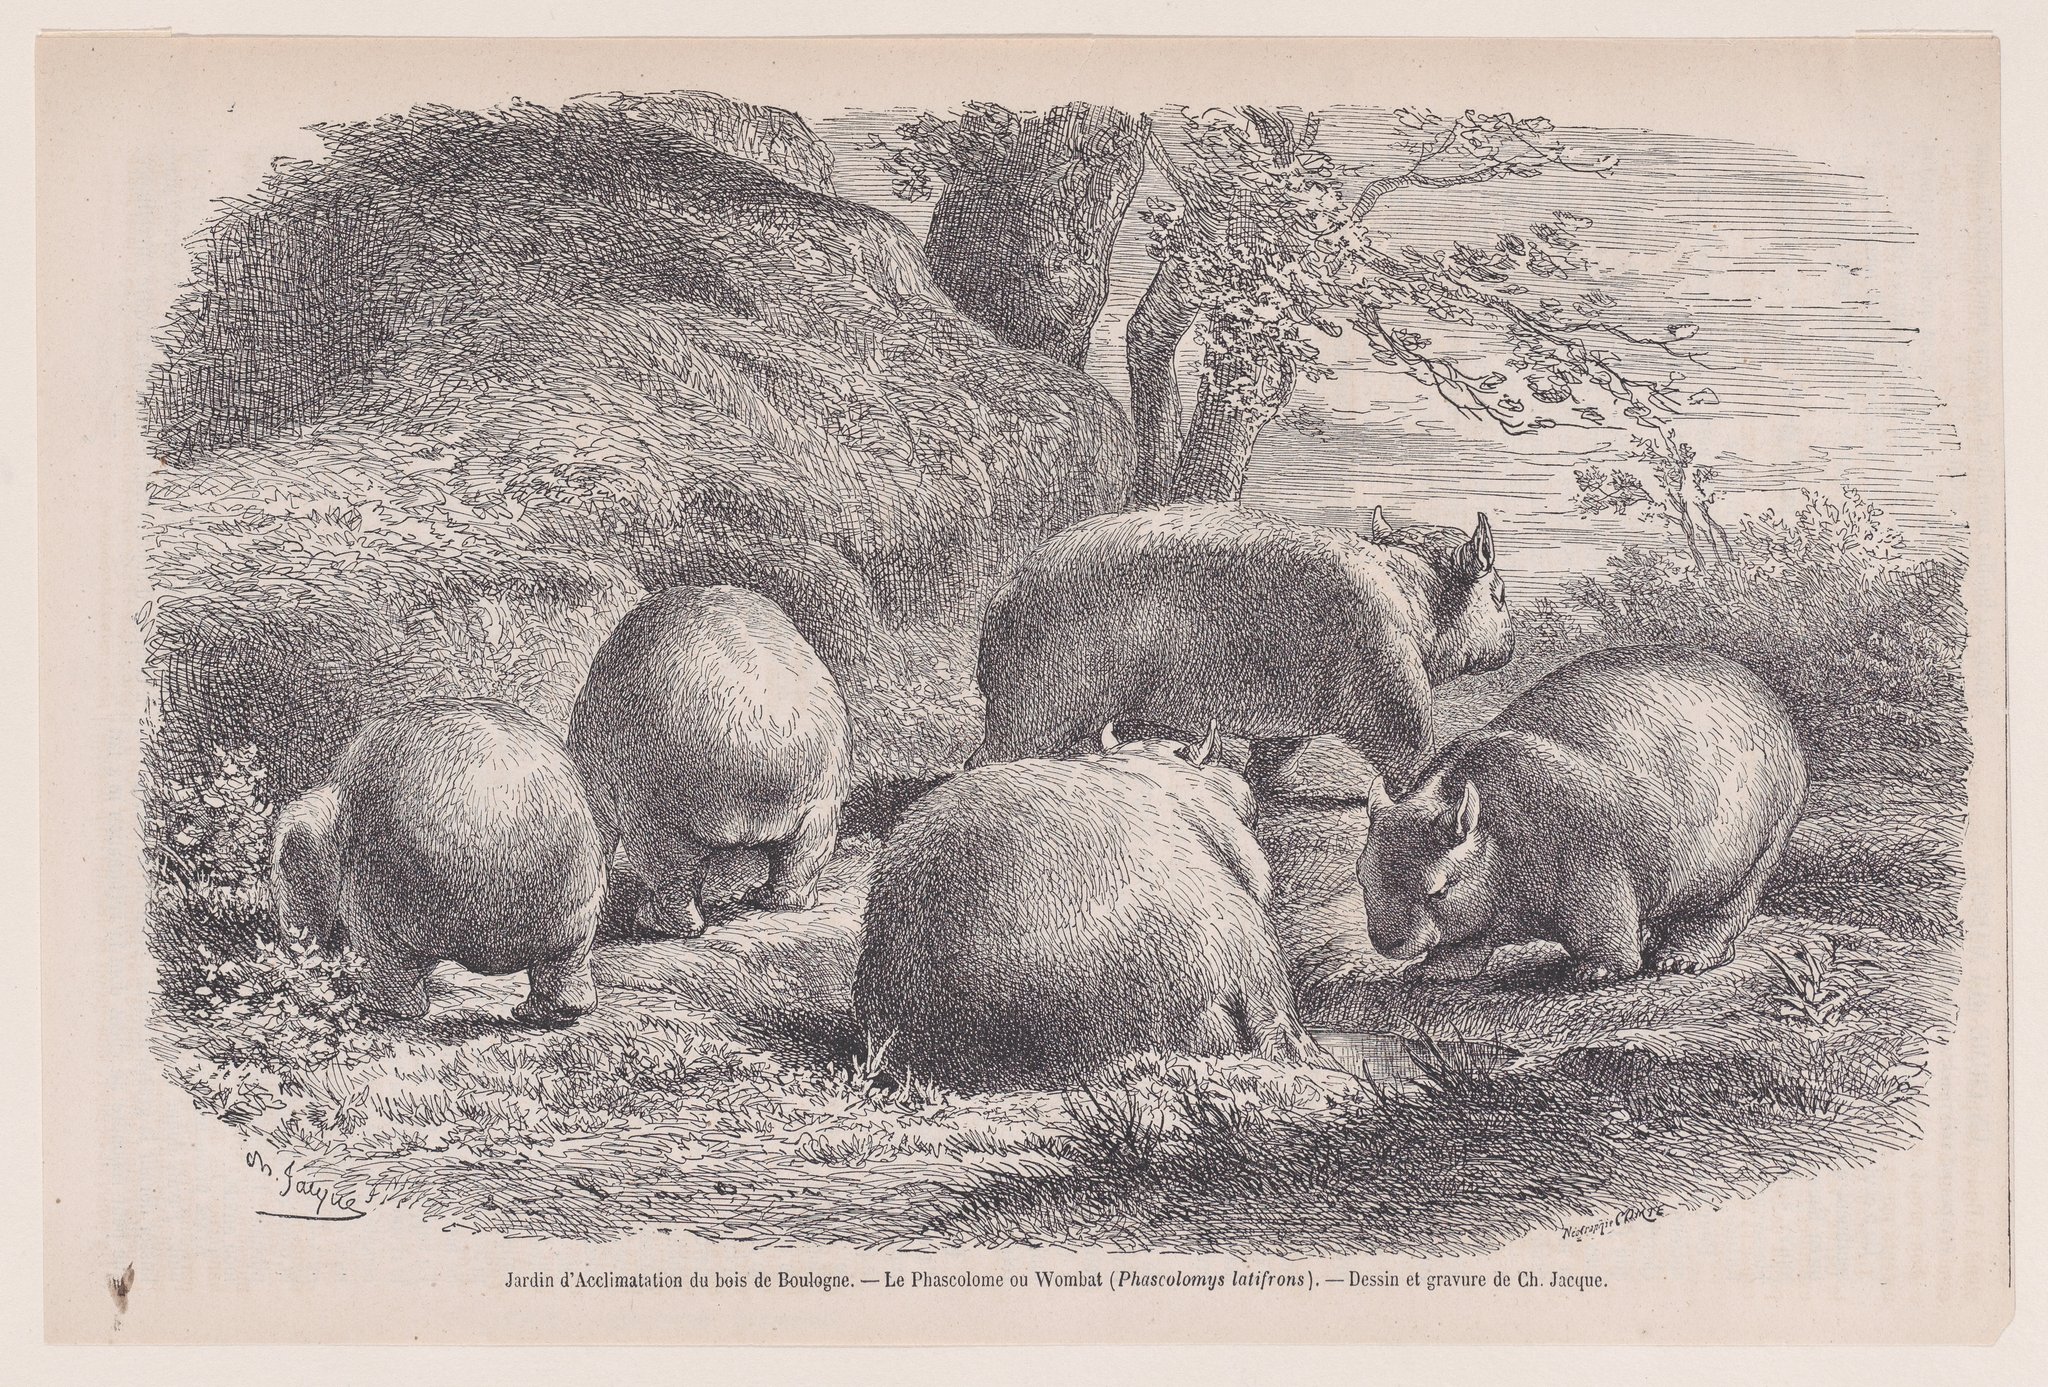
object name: print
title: The Wombat, from "Le Magasin Pittoresque"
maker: charles émile jacque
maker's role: artist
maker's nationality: french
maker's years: 1813-1894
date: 1864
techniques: relief print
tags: animals